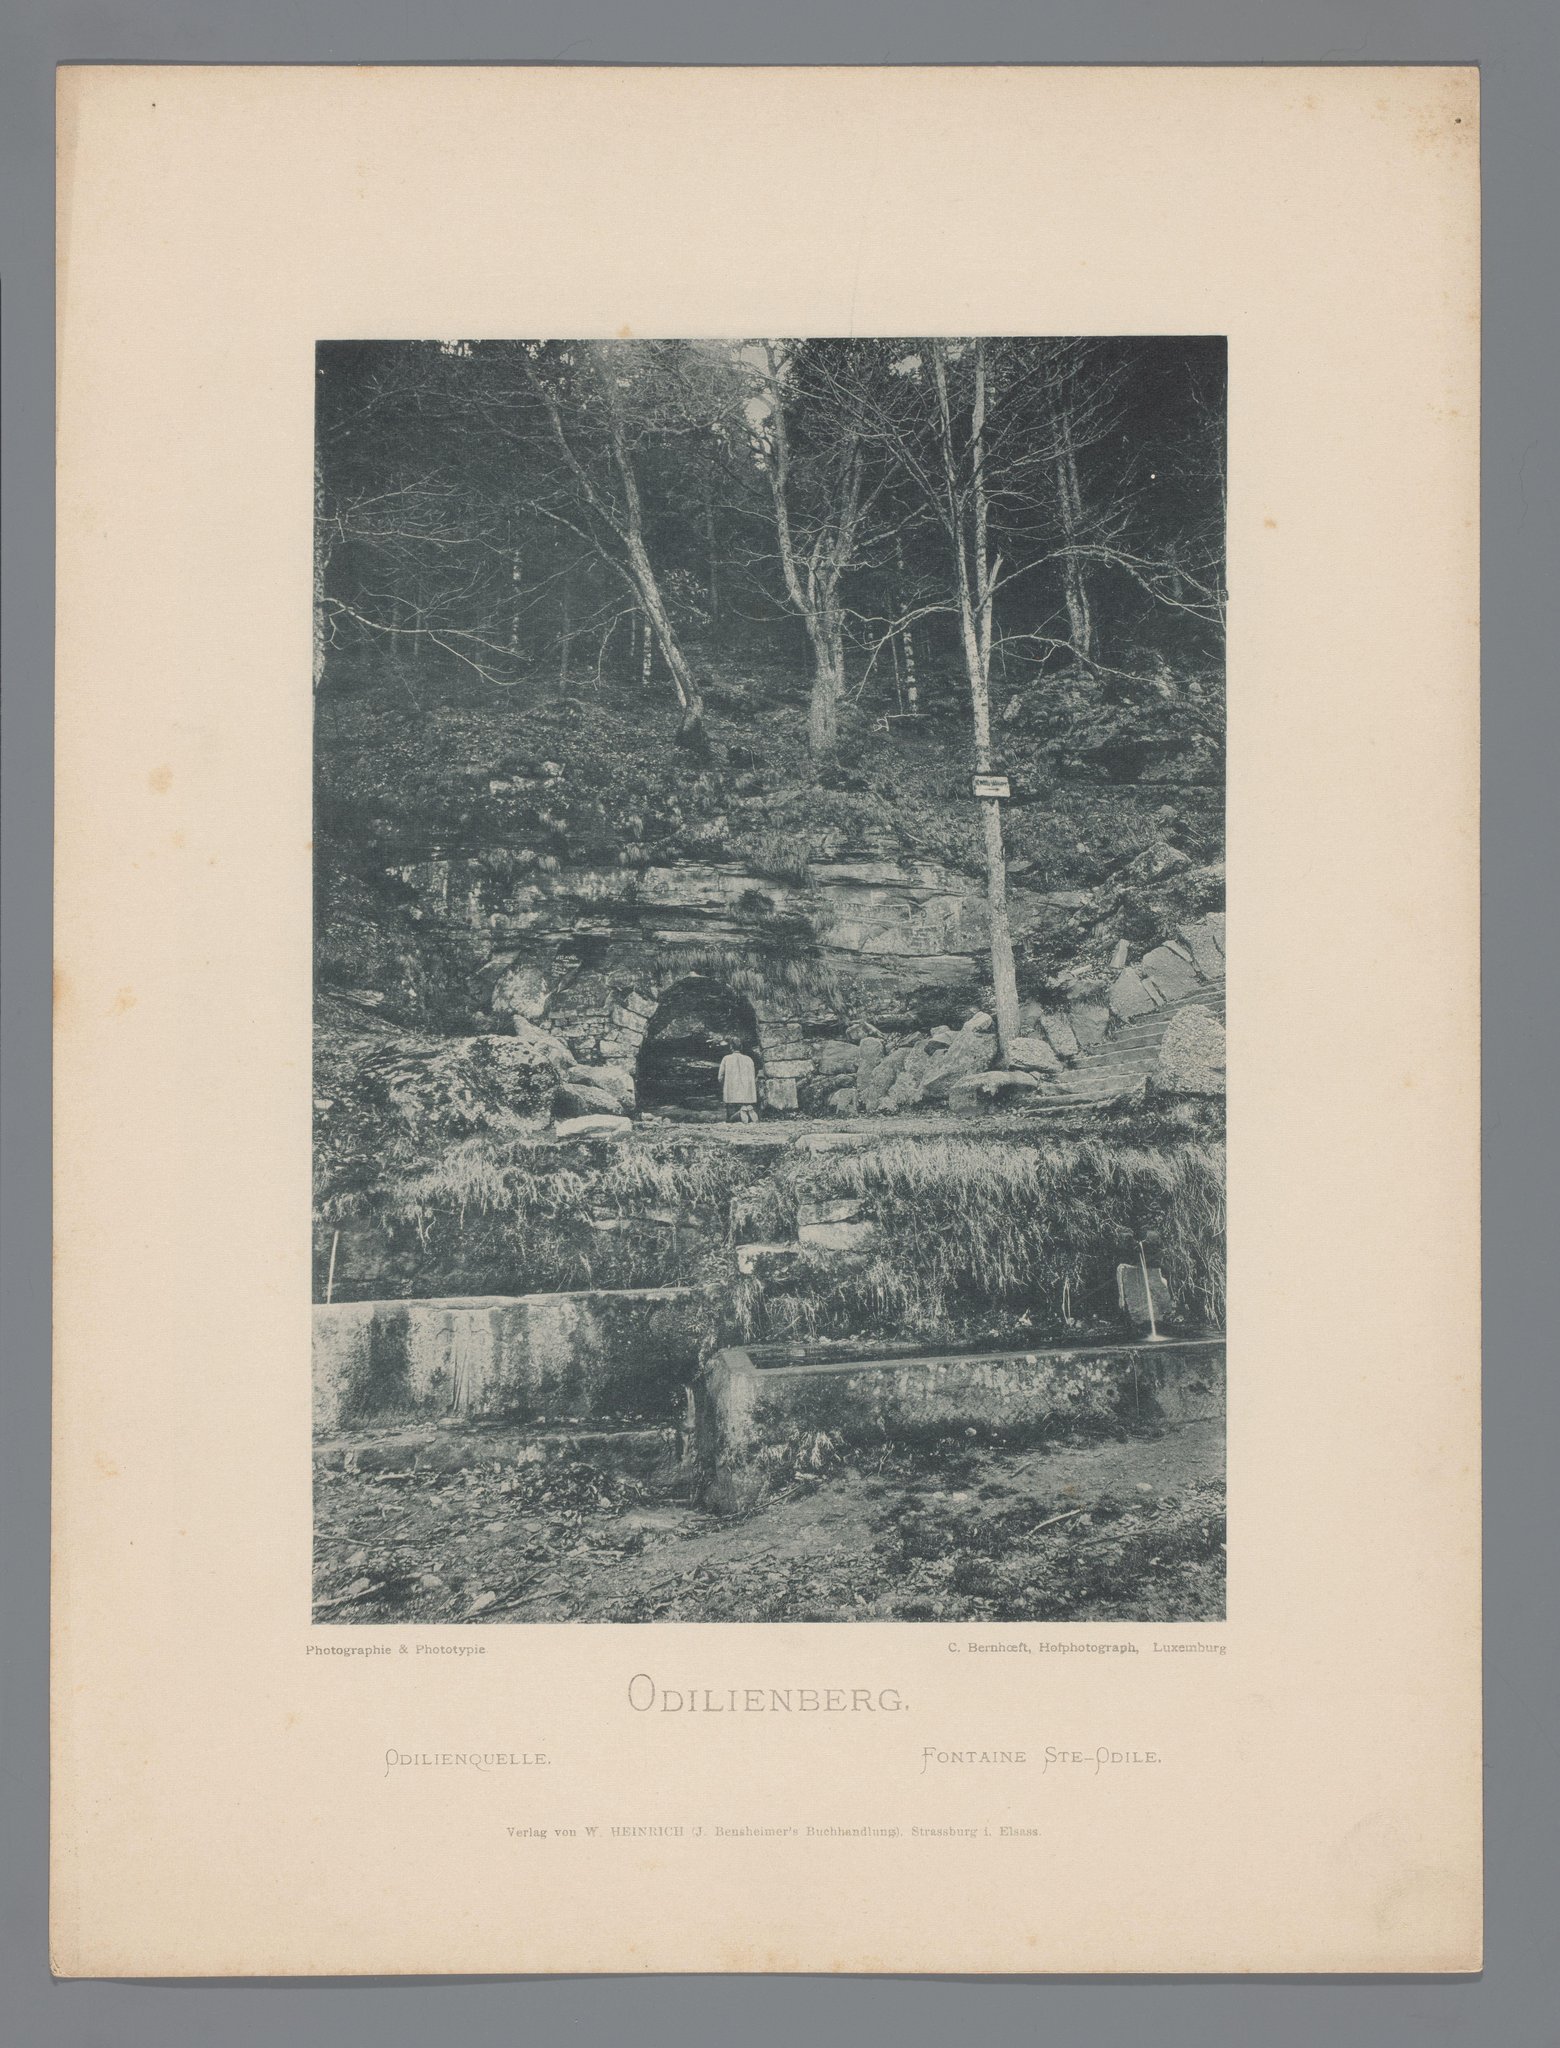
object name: page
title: Odilienberg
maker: charles bernhoeft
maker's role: publisher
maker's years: 1859-1933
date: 1889-1894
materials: paper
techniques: photograph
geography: straatsburg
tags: mountains (+ landscape with figures, staffage), one person praying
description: Deze prent maakt deel uit van een omslag met 100 prenten.